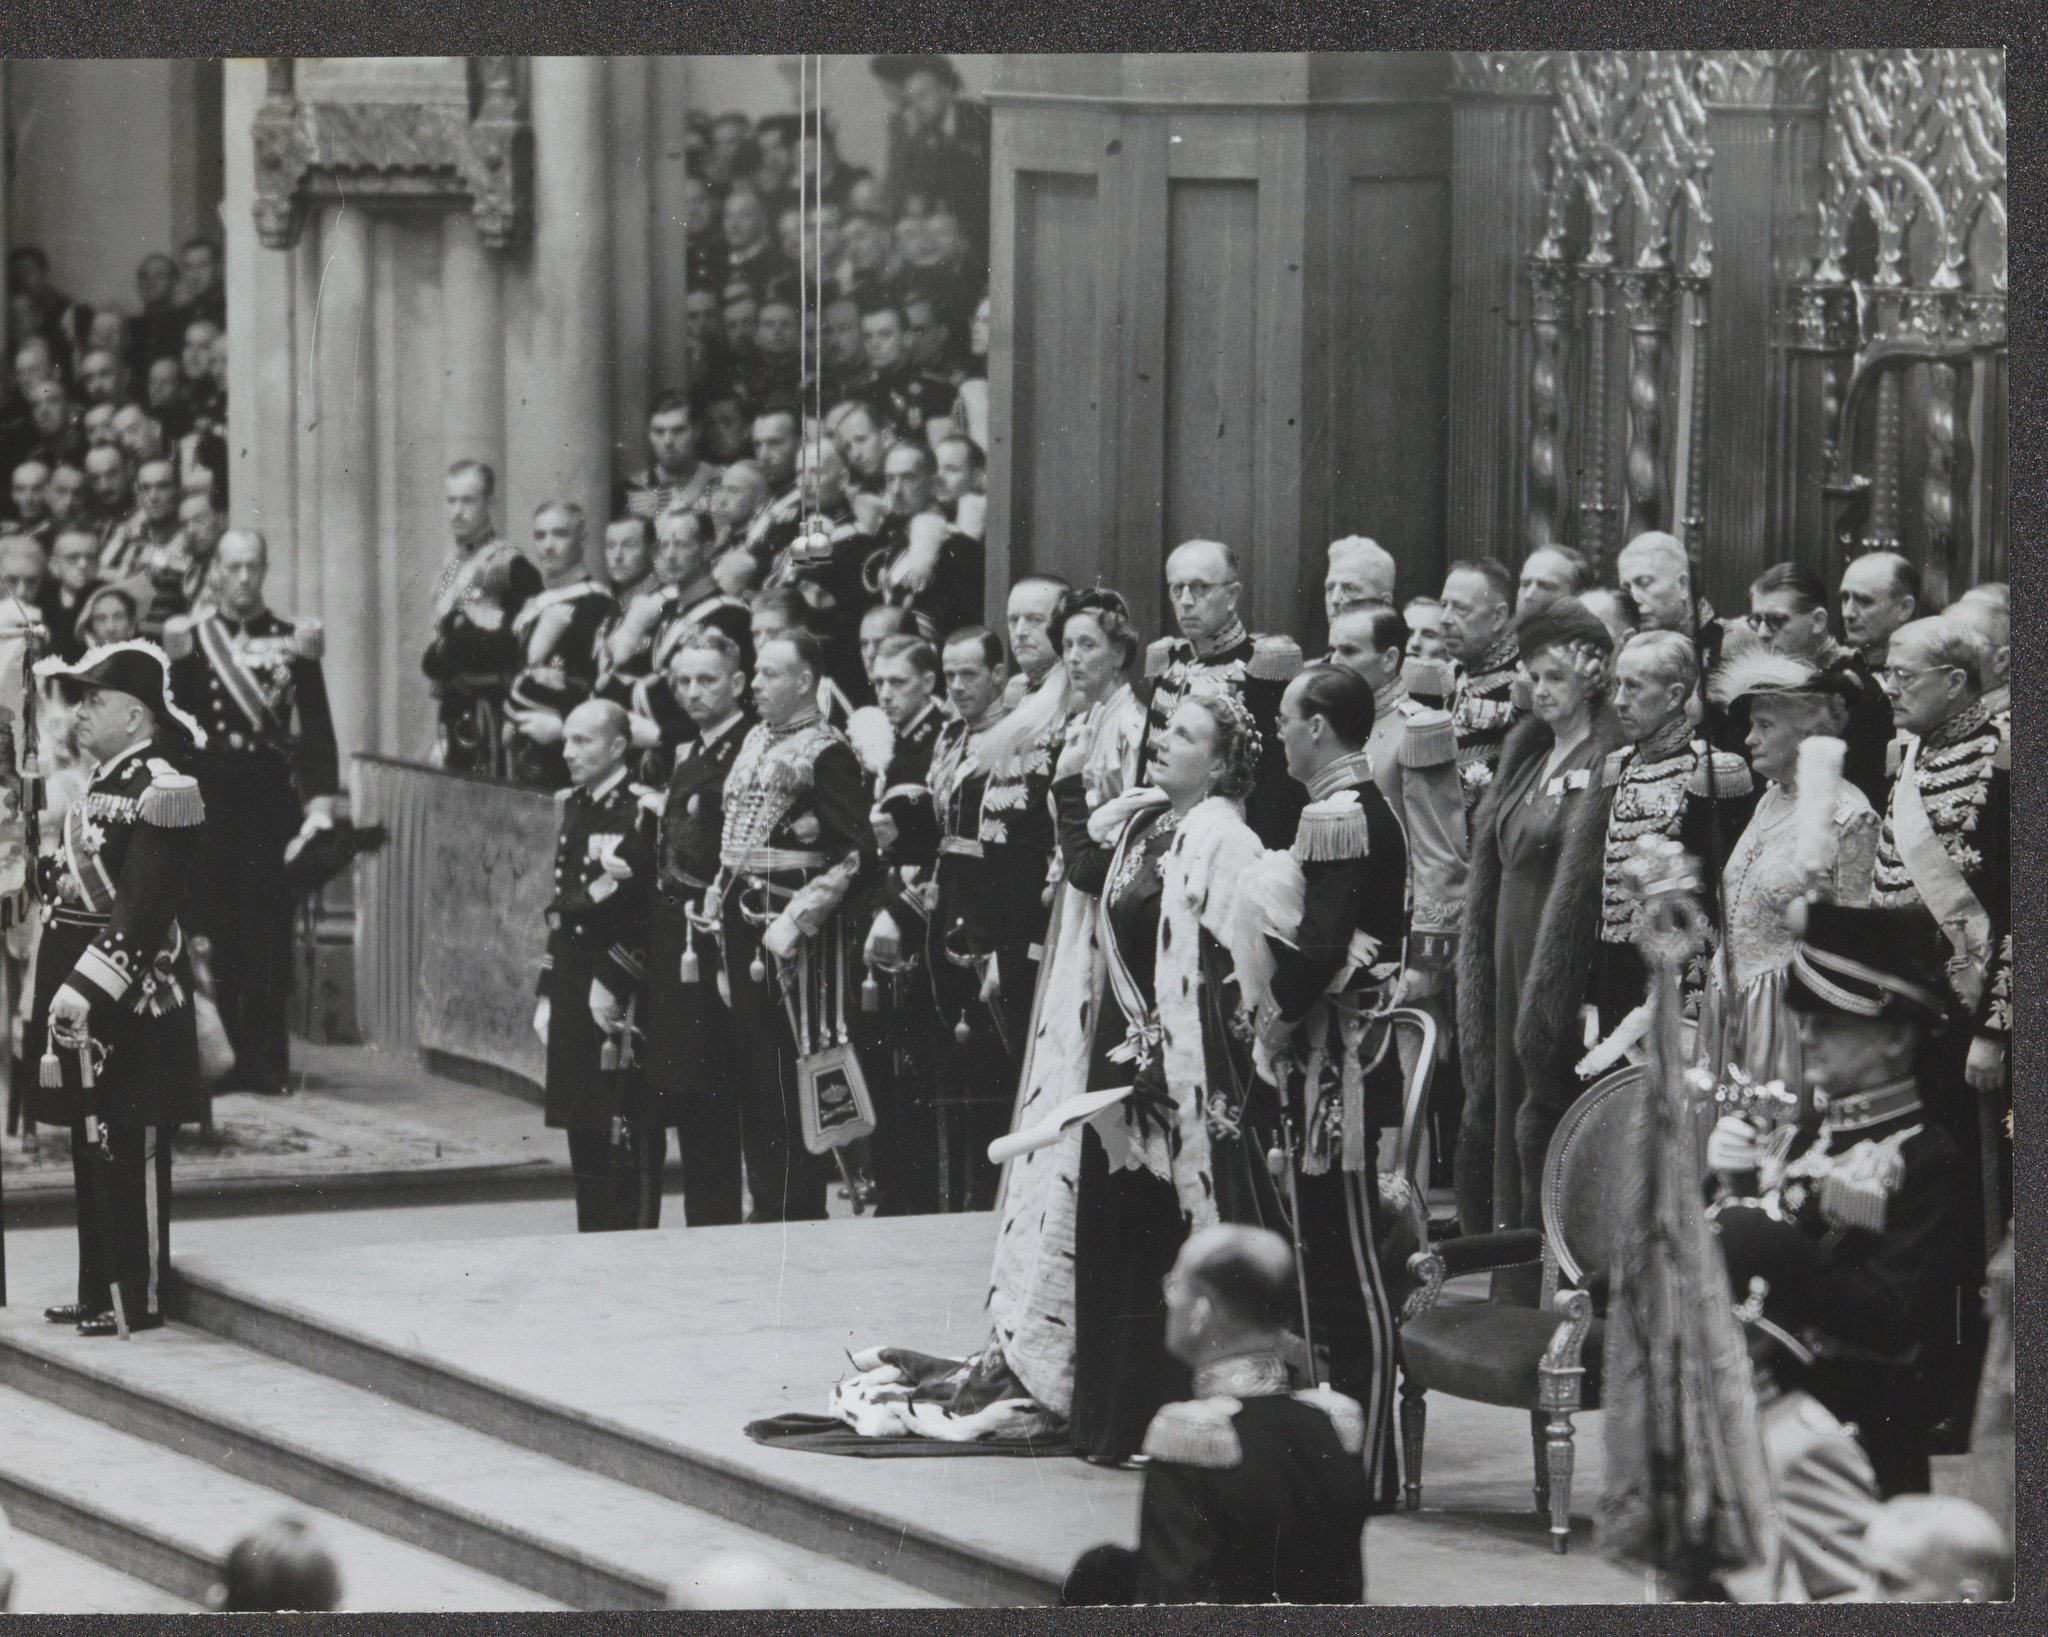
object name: photograph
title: Koningin Juliana legt de eed af voor het koningschap, omringd door toeschouwers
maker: Anonymous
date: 1948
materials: photographic support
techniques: gelatin silver print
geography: amsterdam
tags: utrecht, bernhard (prins der nederlanden), the hague, juliana of the netherlands, historical persons - bb - woman, queen, during the coronation